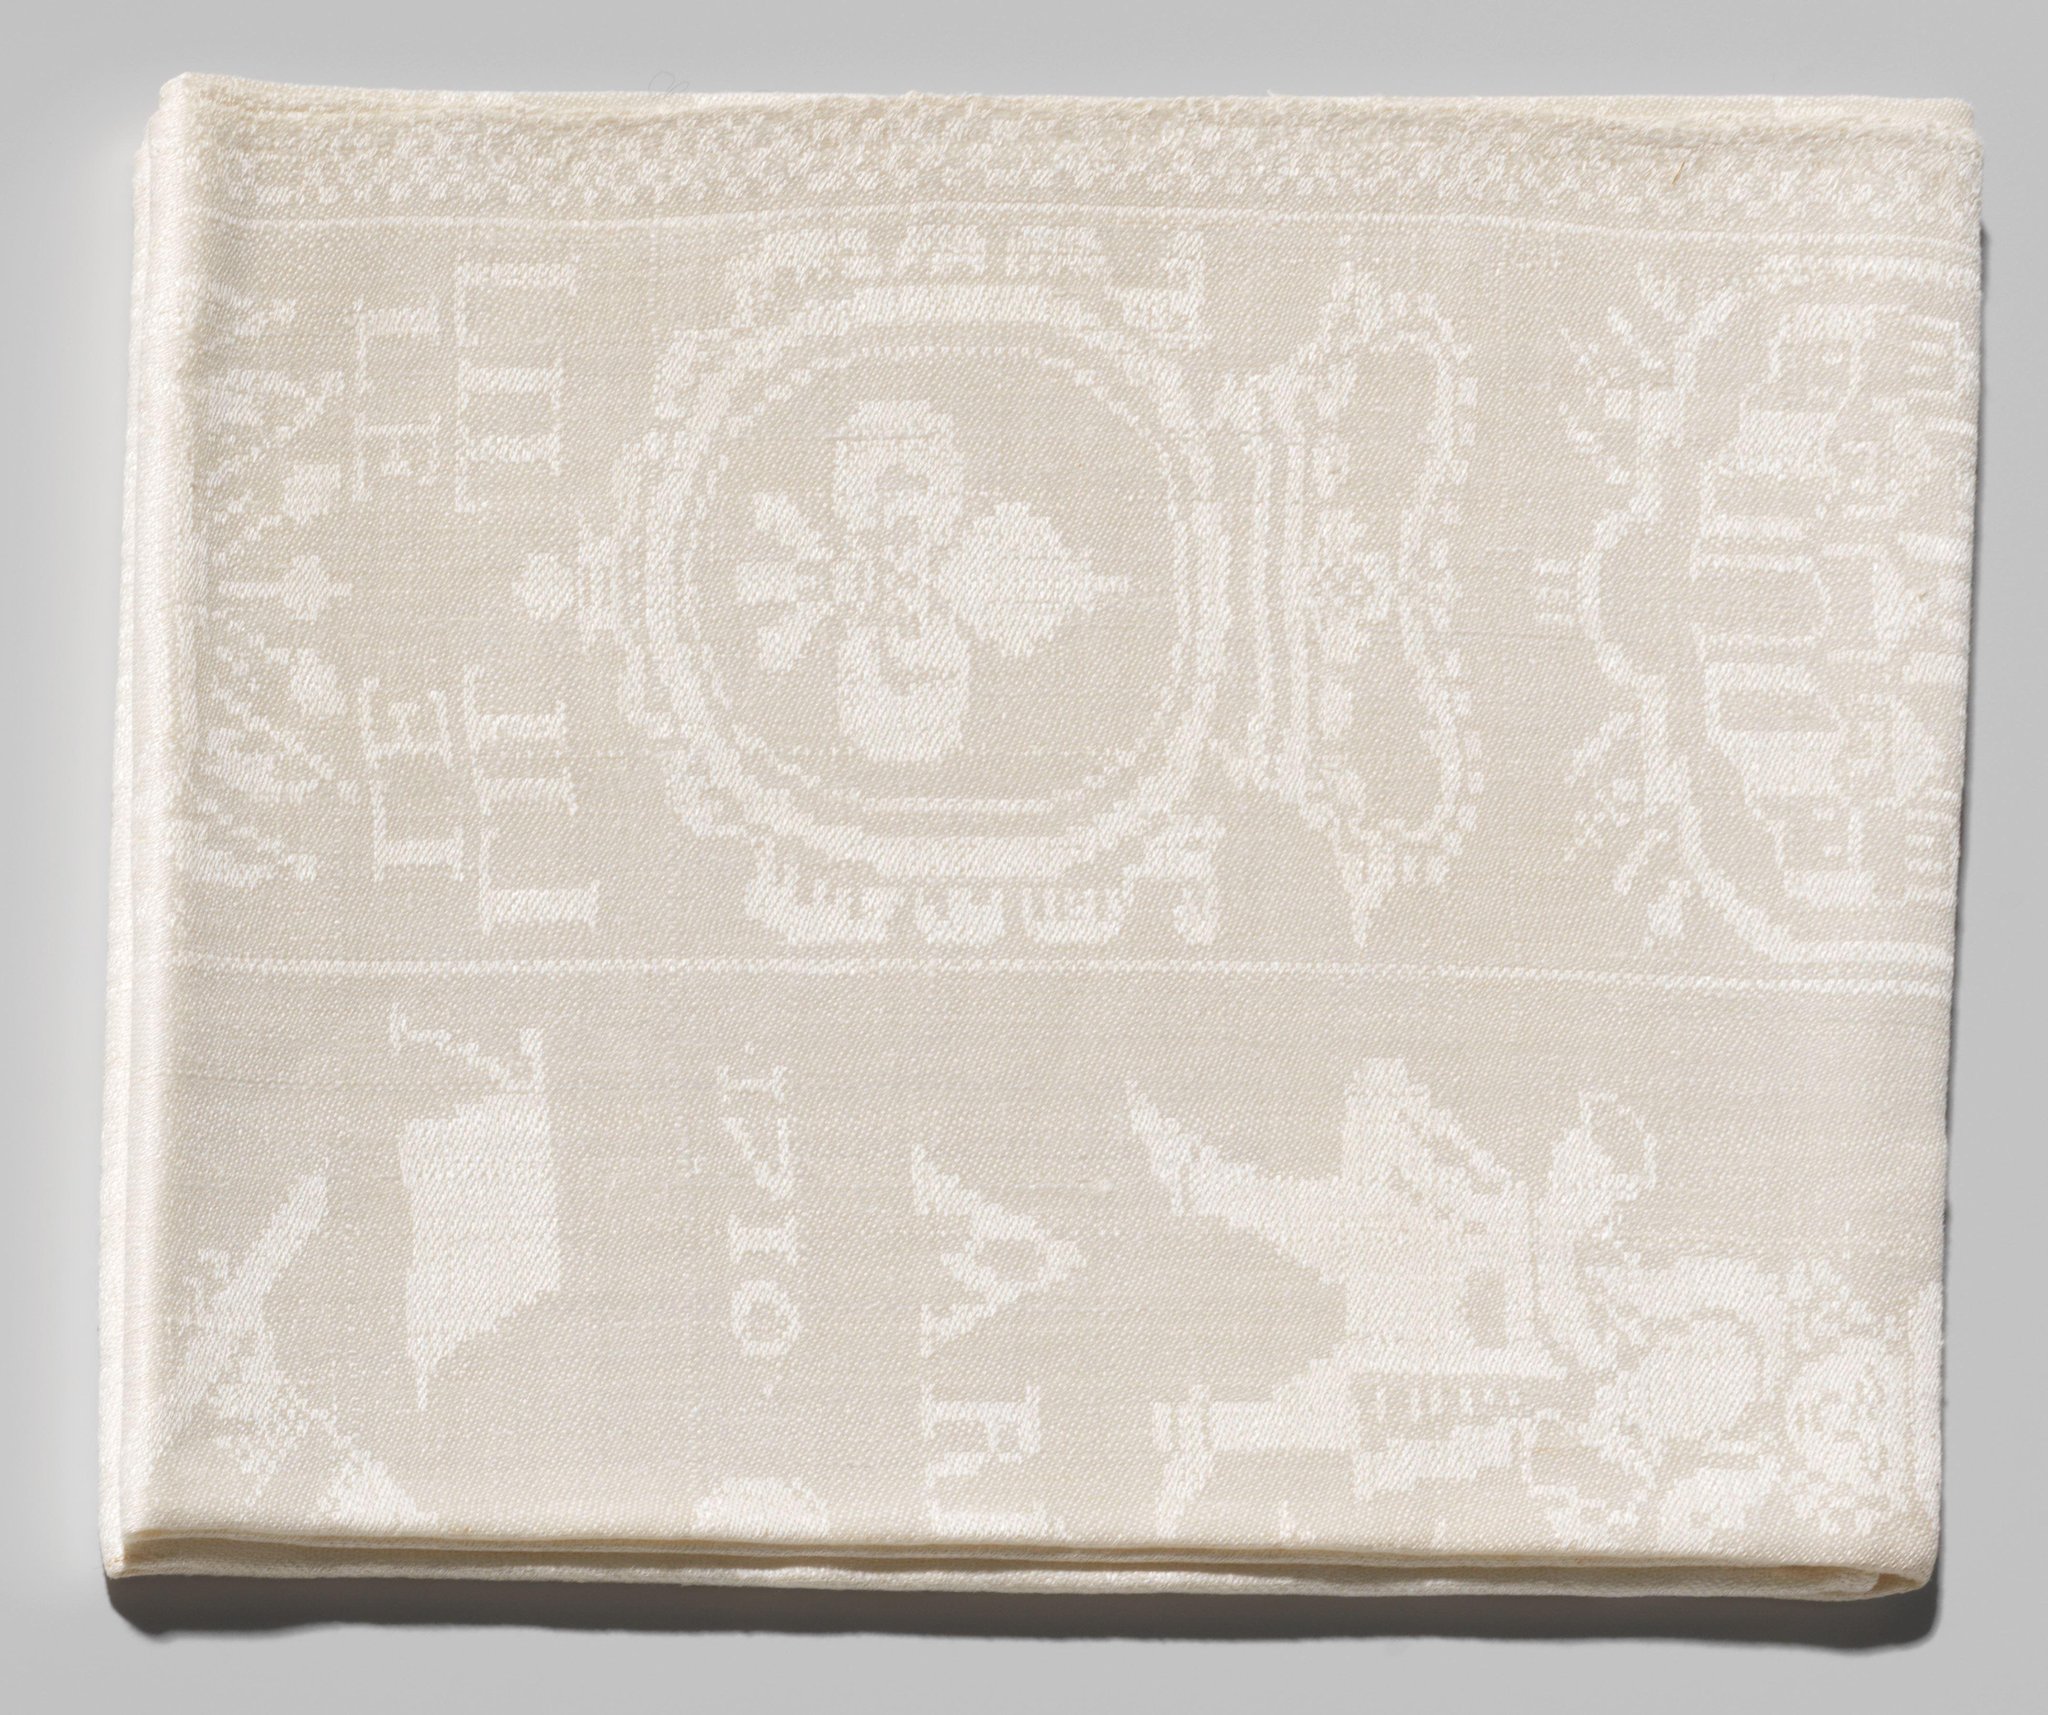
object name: napkin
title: Servet met de inname van Aire en Douai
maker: Anonymous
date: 1710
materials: linen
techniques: damask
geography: kortrijk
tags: douai, aire-sur-la-lys, inname van aire (1710), inname van douai (1712)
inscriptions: mark: ‘TVG 13’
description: Servet van linnendamast met de inname van Aire en Douai (en Béthune?). Middenveld: Het symmetrisch verdubbeld patroon vertoont van onder naar boven drie taferelen: 1 Steigerend paard, naar het midden gericht en bereden door een veldheer in justaucorps, breedgerande hoed met veer. 2 Beschieting van een stad door twee kanonniers en een officier. Terzijde het onderschrift ARIEN 1710. 3 Gekroond wapen van Habsburg op een krans van vlaggen en wapens, geflankeerd door het wapen van Groot-Brittannië en Ierland. Middenboven DOUAY.Staande en liggende randen: ovale wapenschilden afgewisseld met stadsgezichten in gelobde medaillons met opschriften: TOURNAY, LILLE, MEENEN en OSSTENDE. Rondom: blokkenrand.